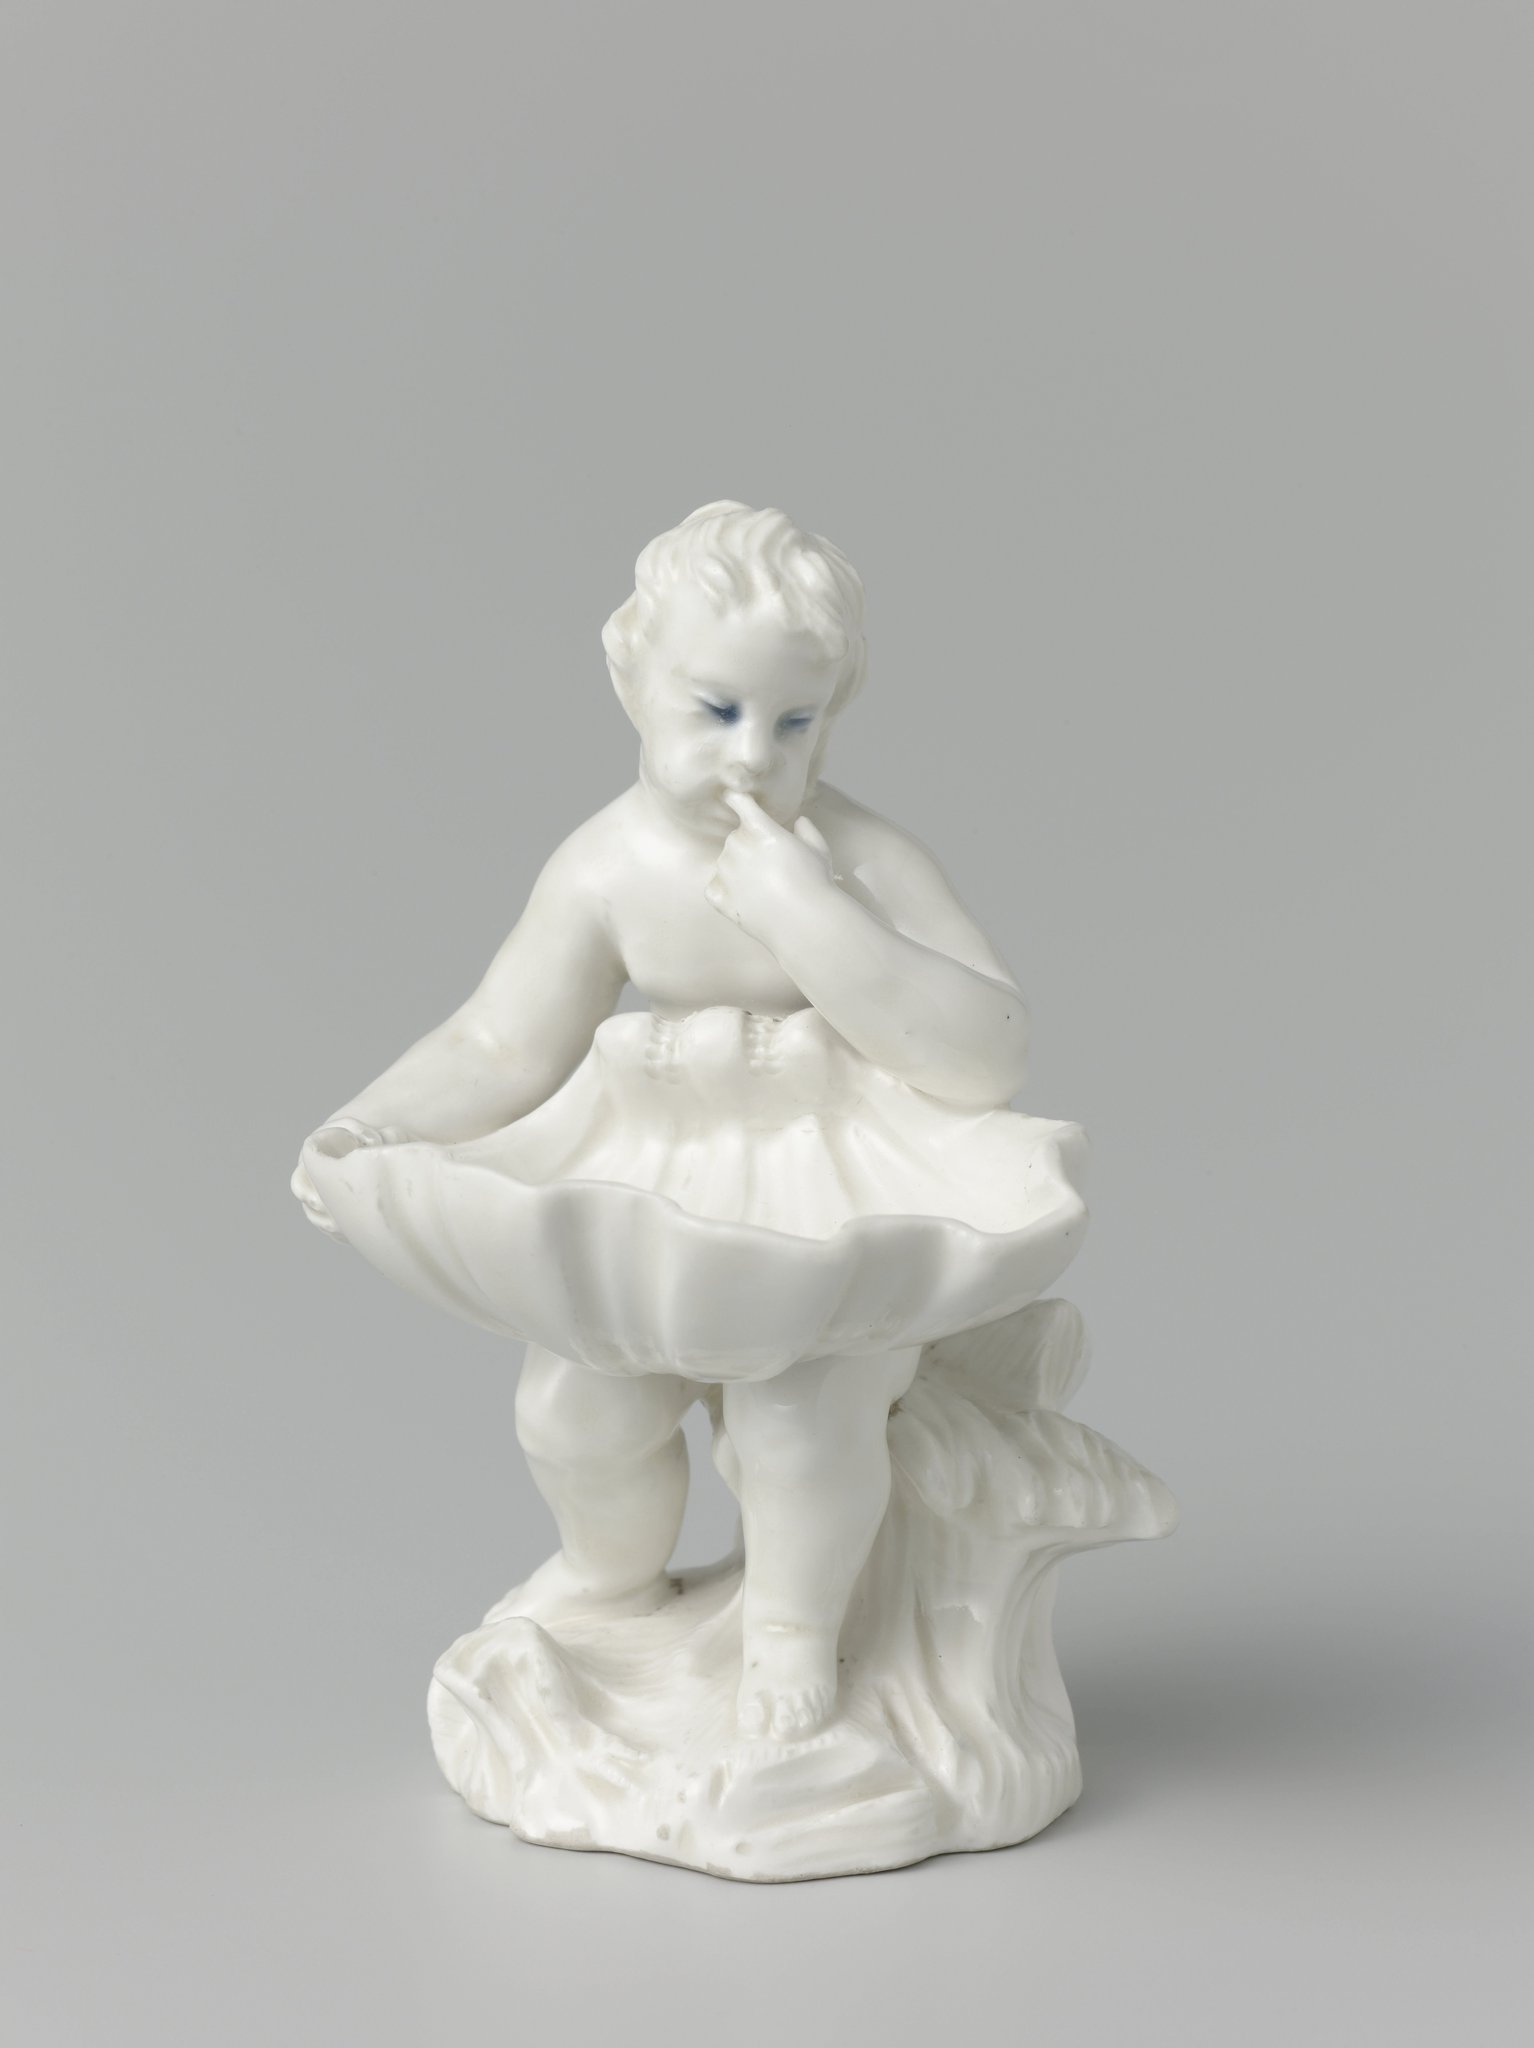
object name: salt condiment vessel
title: Salt cellar in the shape of a putto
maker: nicolas-joseph gauron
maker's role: keramiekontwerper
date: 1764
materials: porcelain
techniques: painted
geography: weesp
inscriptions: factory mark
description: Weesper porseleinfabriek model attributed to Nicolas Gauron (1736–after 1775) Weesp, c. 1764 hard-paste porcelain